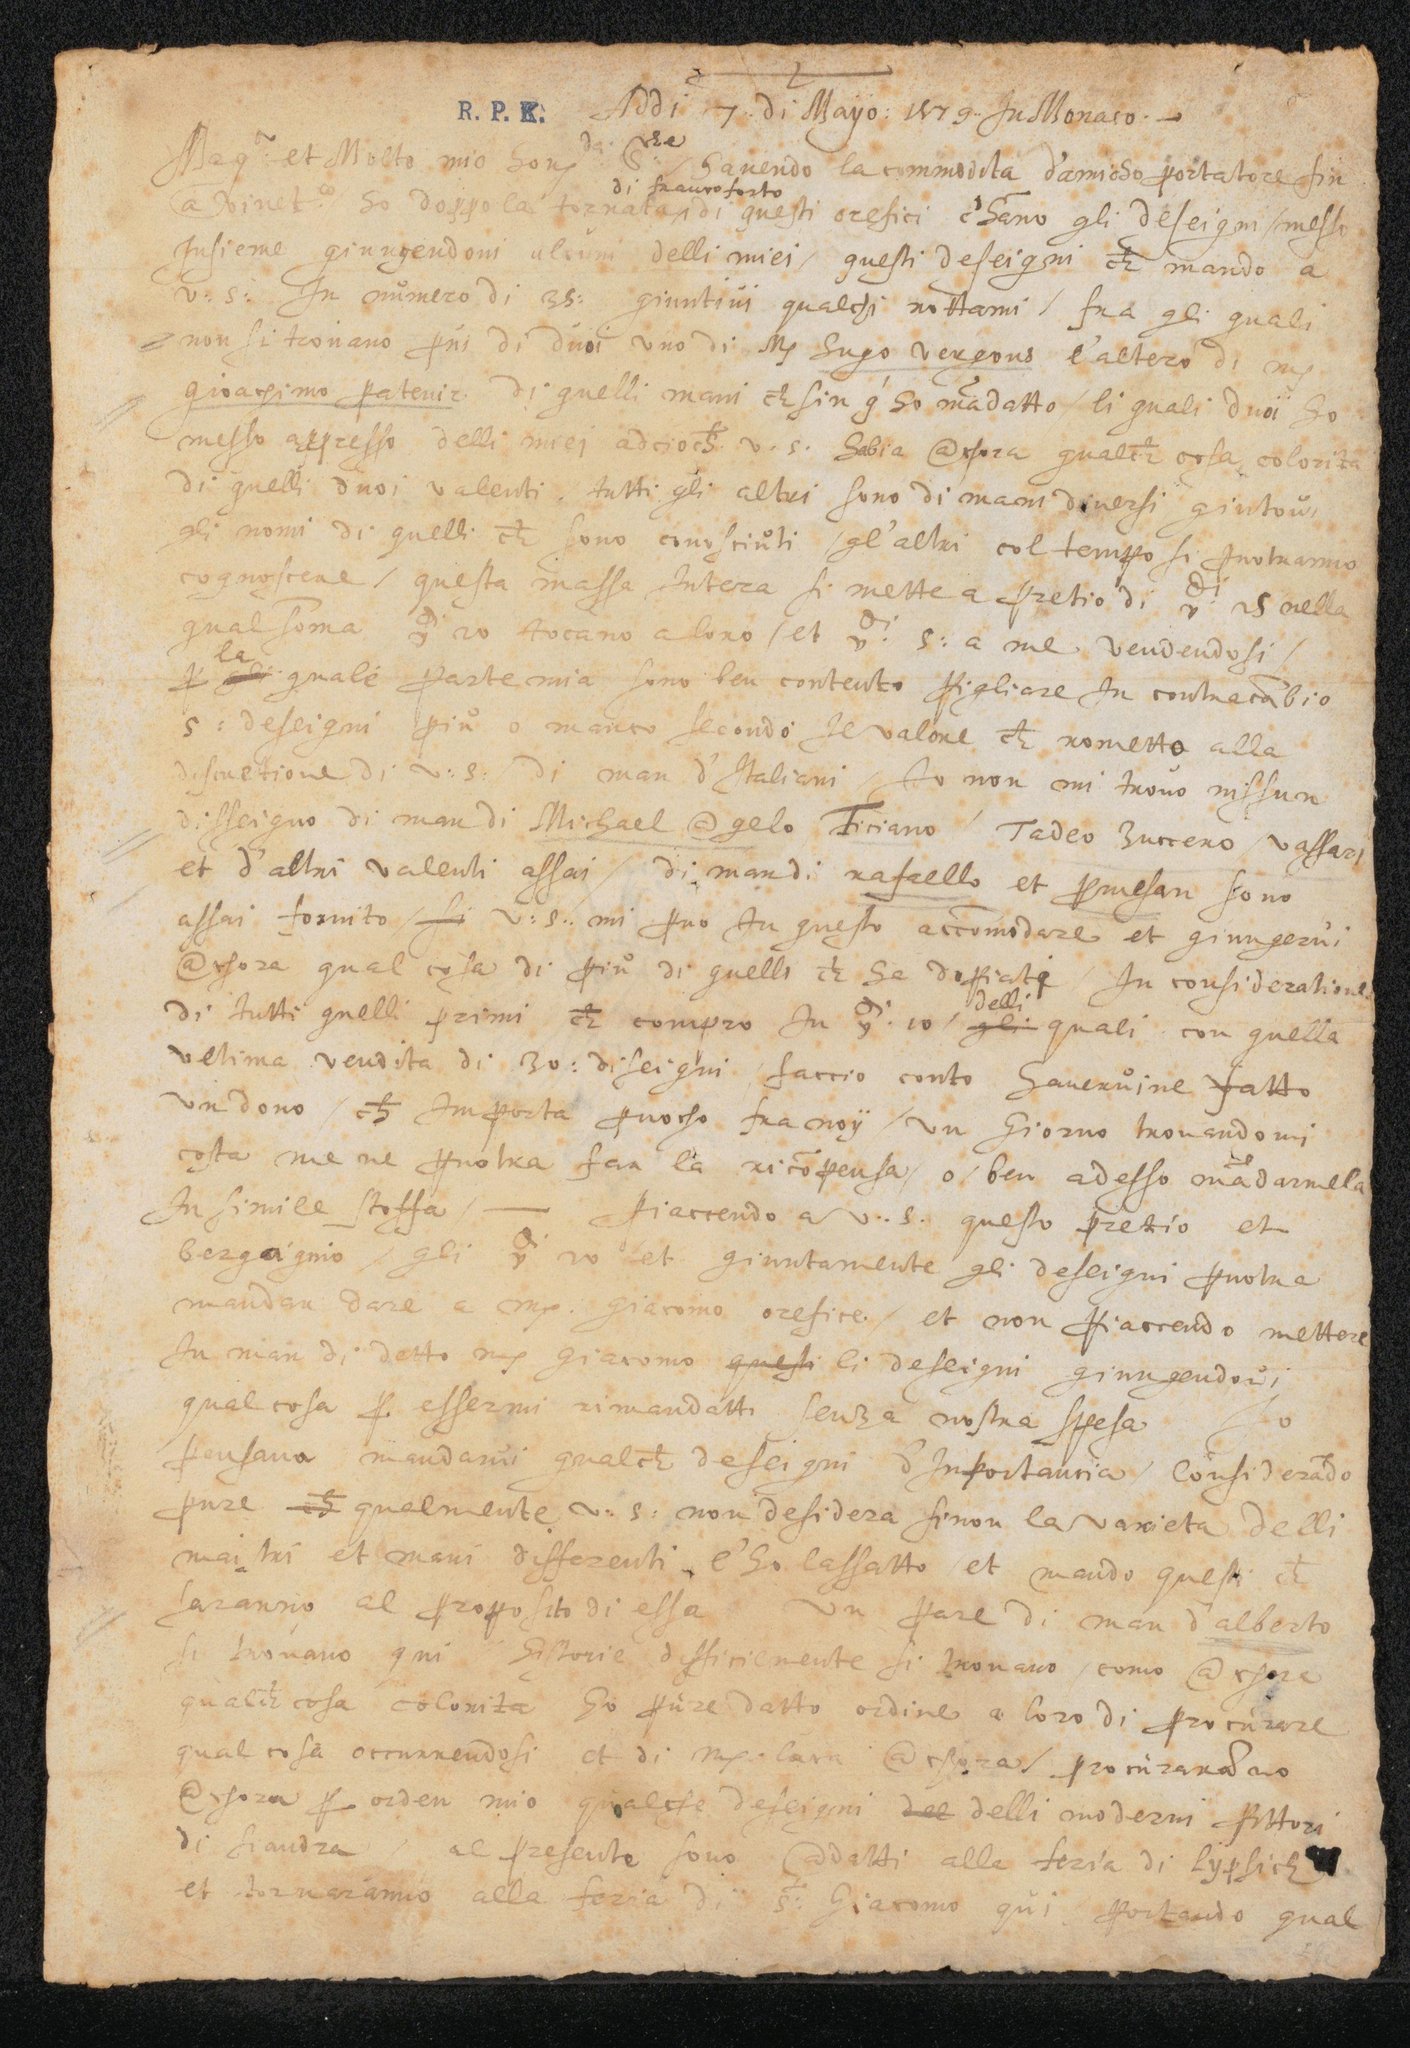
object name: letter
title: Brief aan anoniem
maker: joris hoefnagel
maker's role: draughtsman, painter, print maker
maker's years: 1542-1600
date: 1579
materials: ink, paper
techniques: pen, writing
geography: munich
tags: rafaël, antwerp, joachim patinir, sculptor, michelangelo, venice, painter, draughtsman, titiaan, parmigianino, rome, taddeo zuccaro, giorgio vasari, art trade, art shop, drawing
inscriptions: collector's mark: Lugt 1337, collector's mark: Lugt 2233, watermark